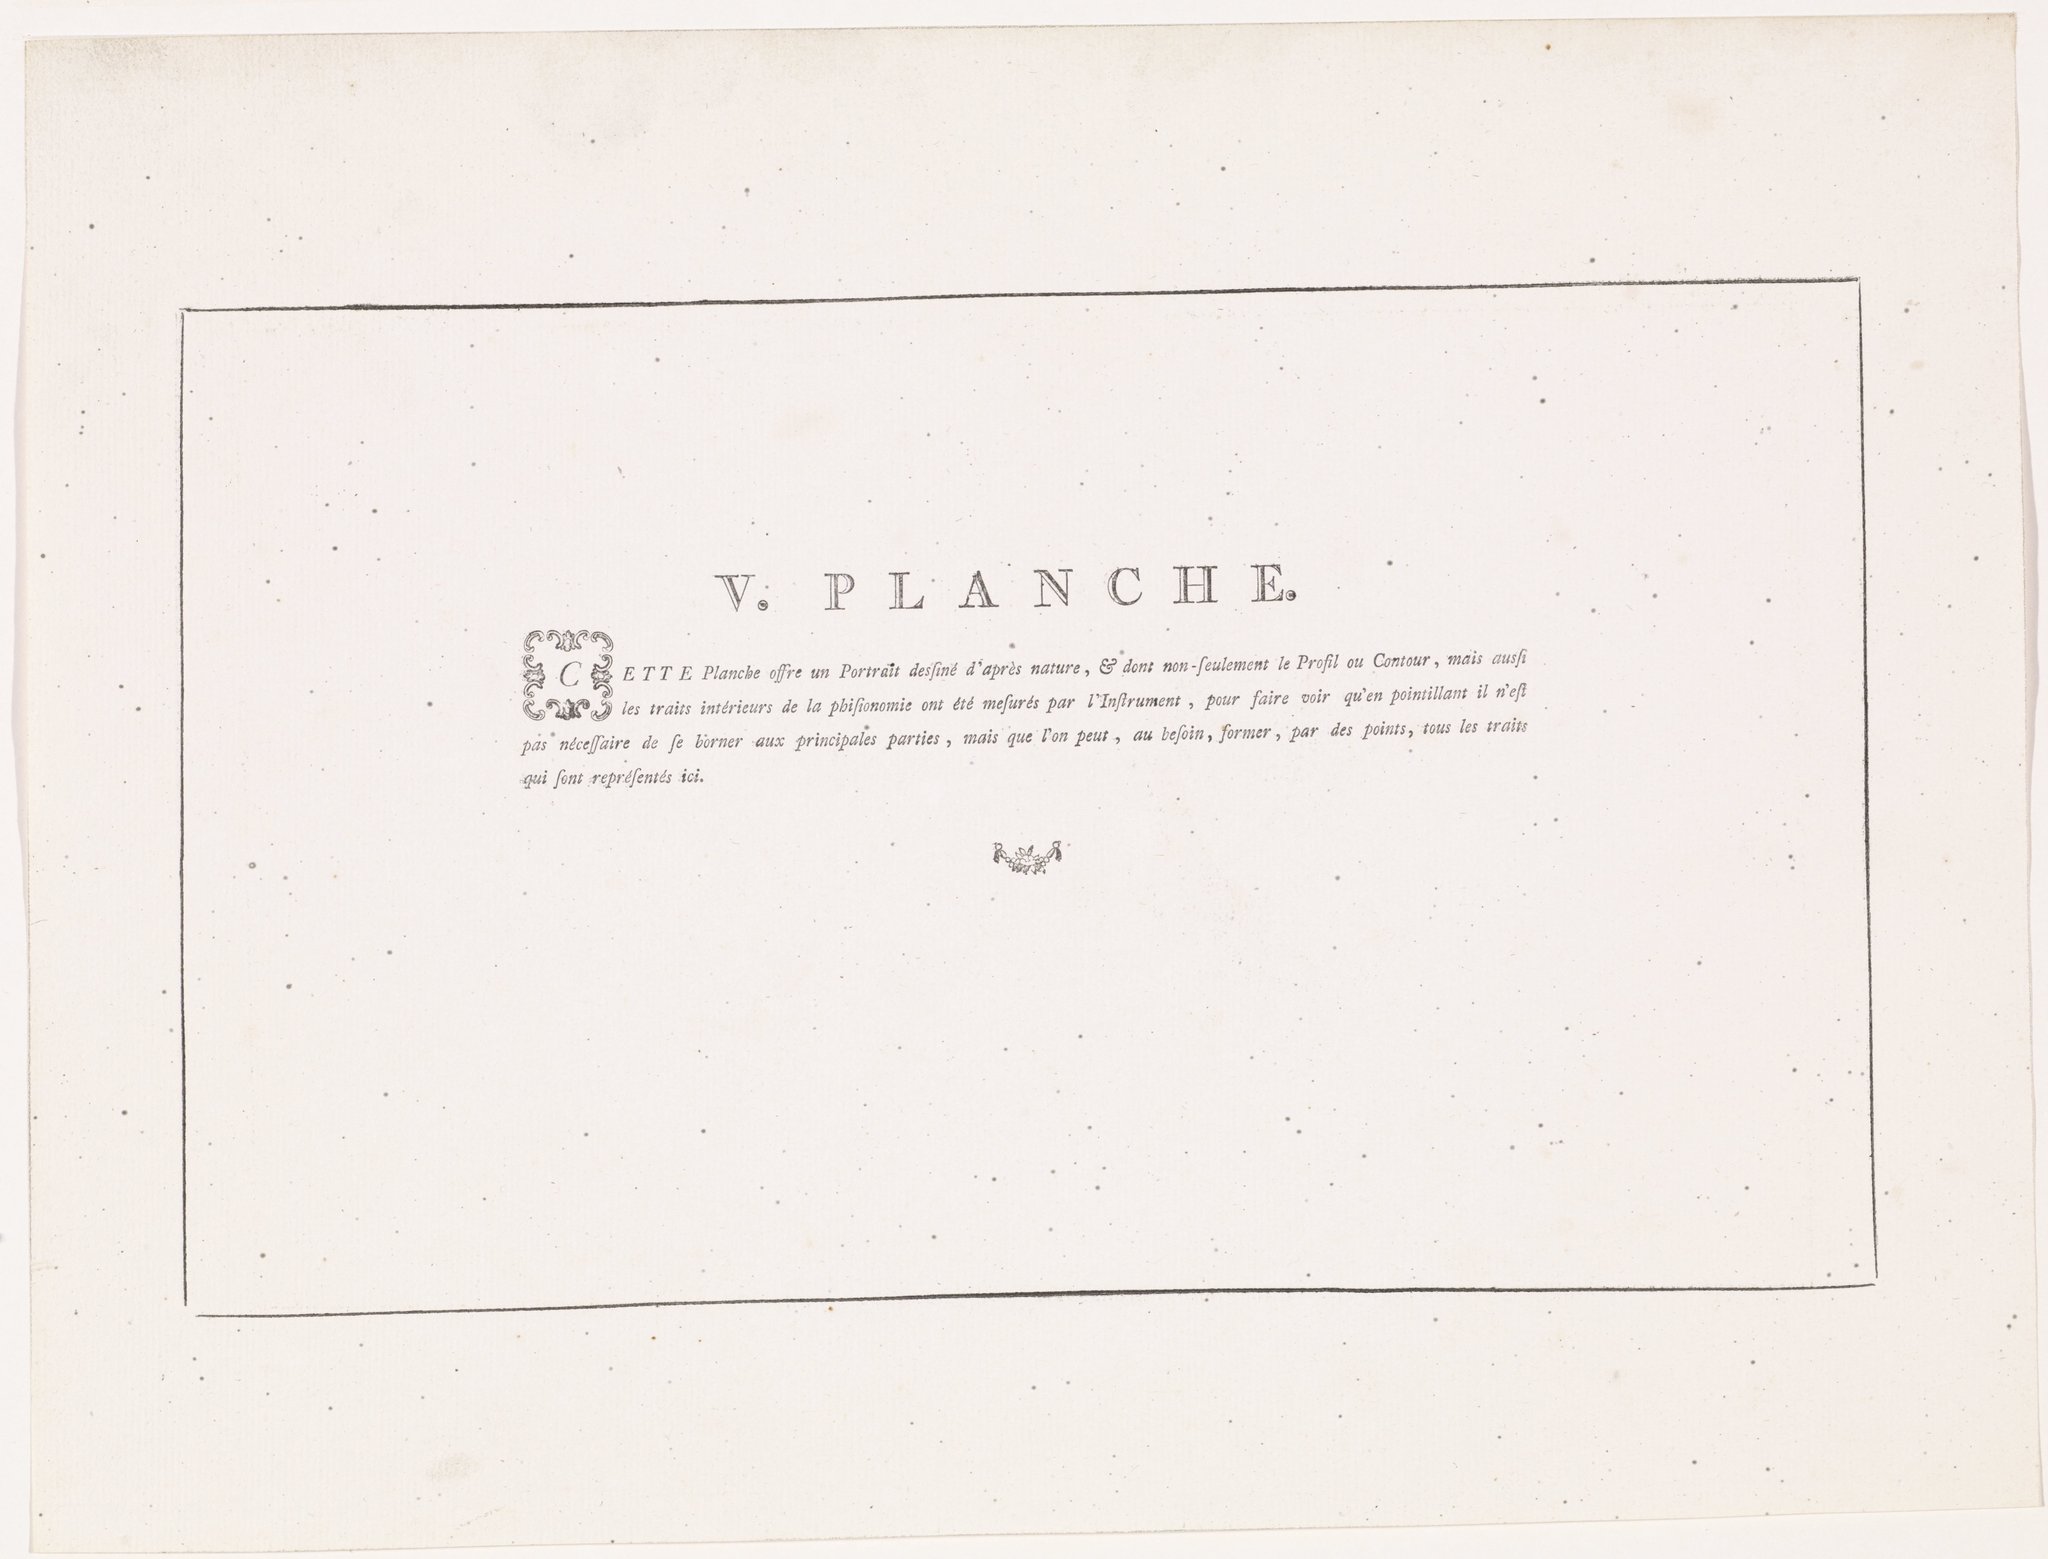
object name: text sheet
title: Toelichting bij het portret van een man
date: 1778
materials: paper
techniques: letterpress printing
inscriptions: collector's mark: Lugt 2228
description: Blad gebruikt in: Eckhardt, Antoine George. Description d'un graphometre universel (...) à dessiner toutes sortes d'objets de la maniere la plus exacte (...) inventé par A.G. Eckhardt. 's-Gravenhage: Jan Hendrik Munnikhuizen, 1778.